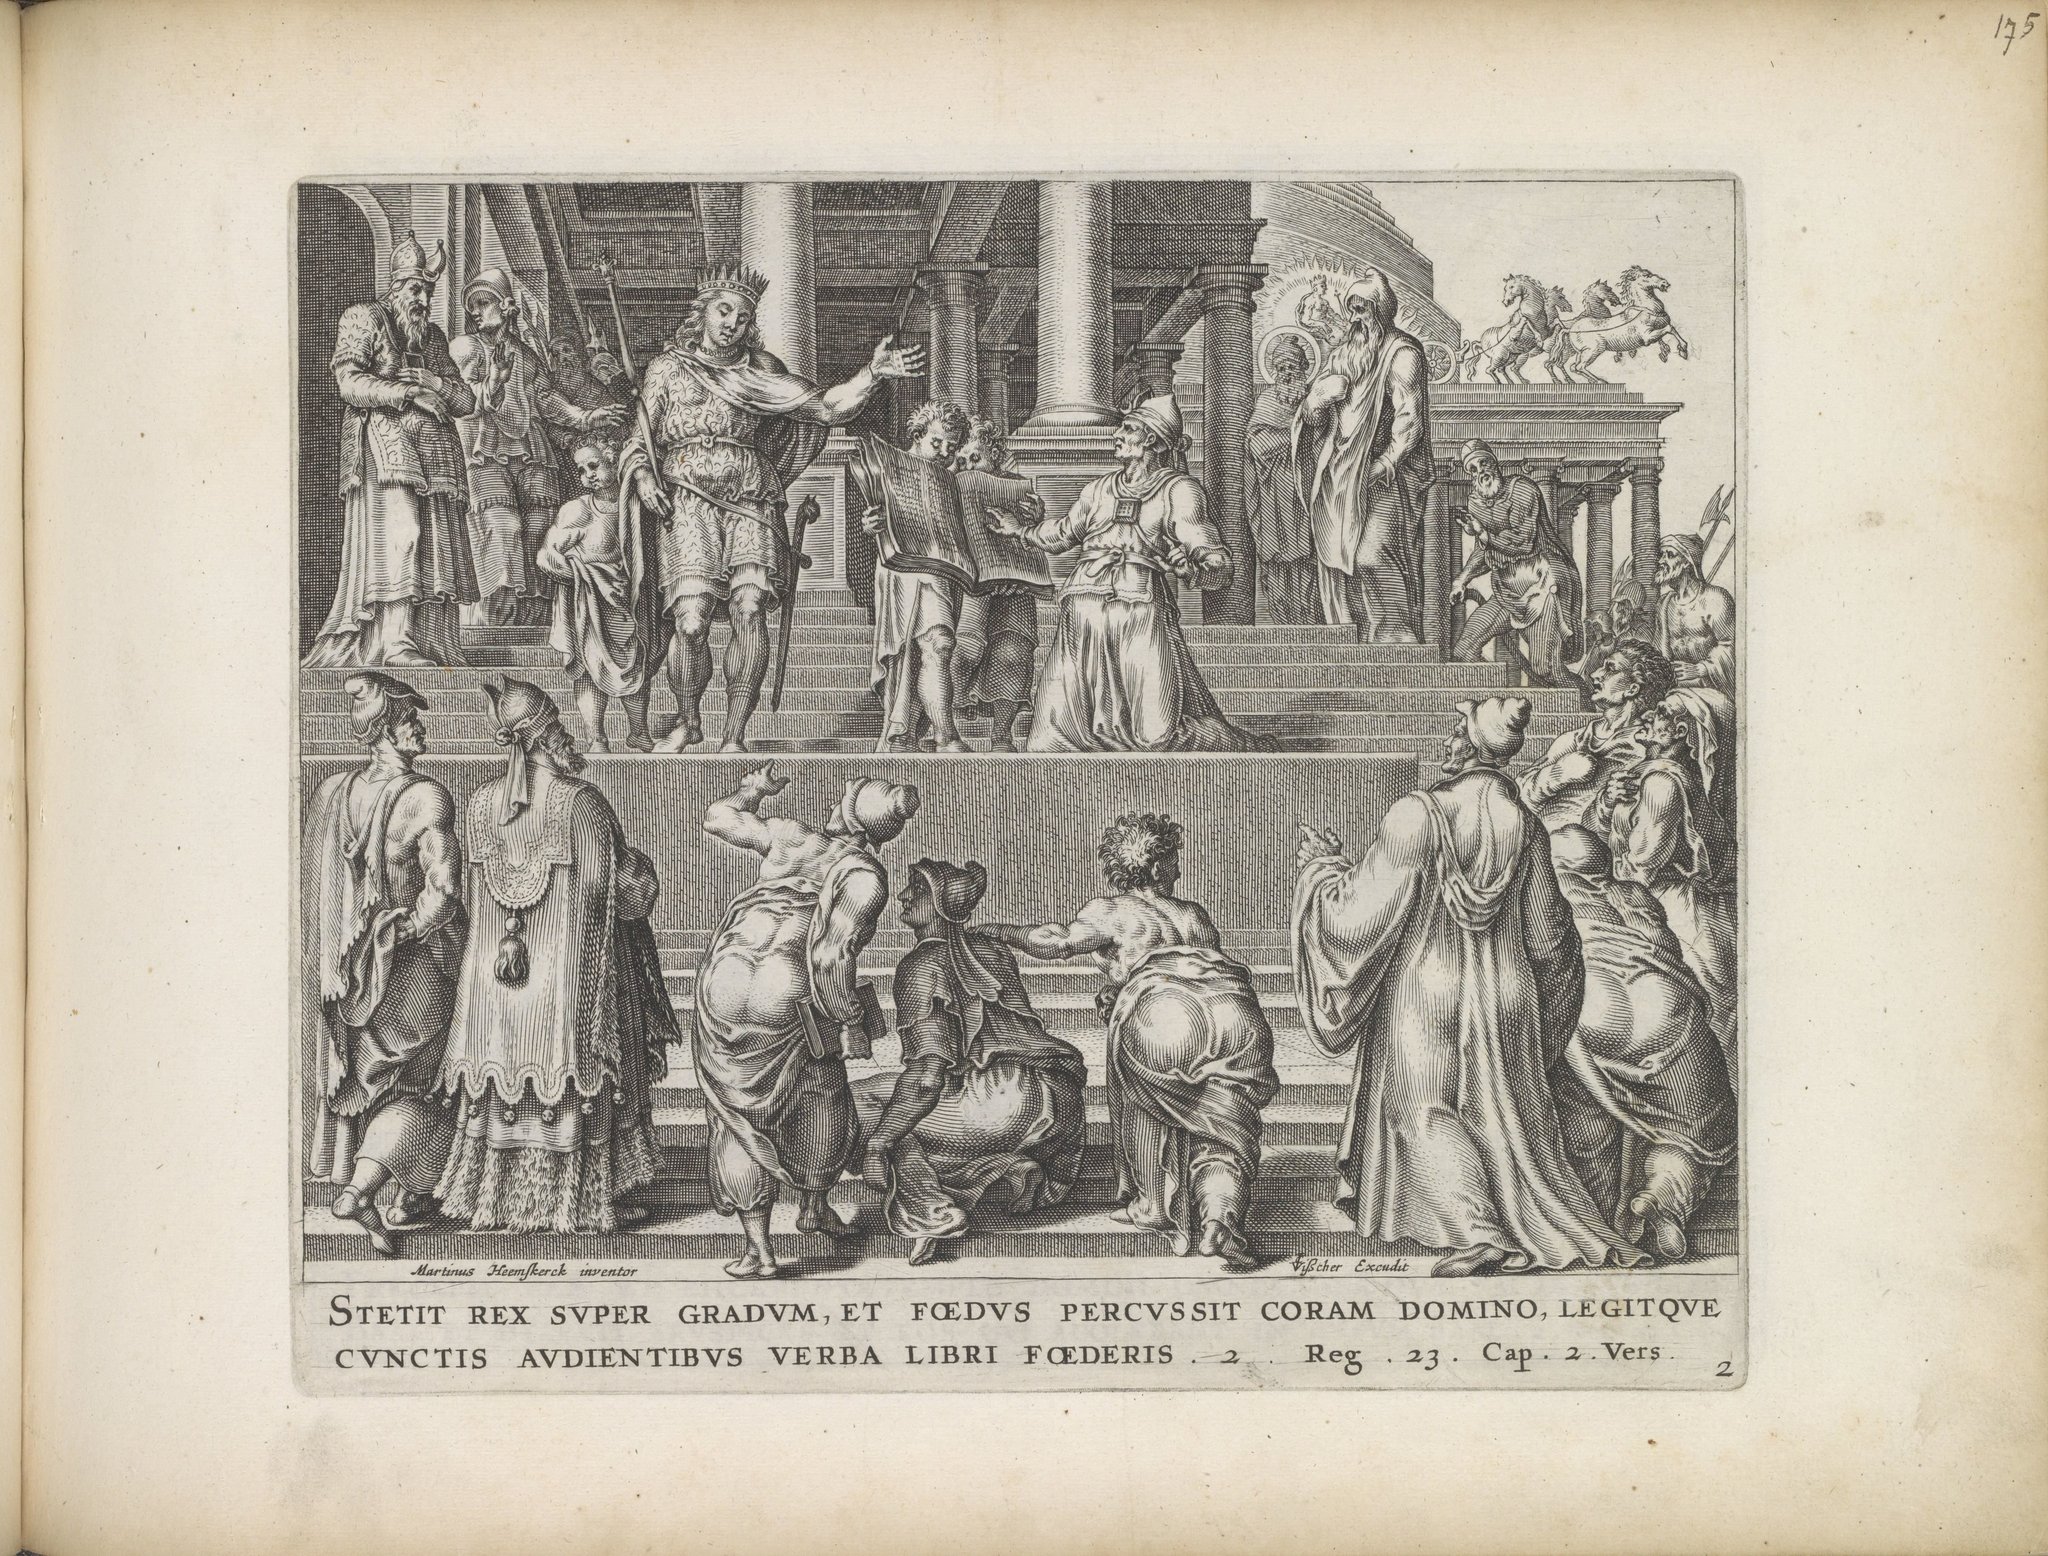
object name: print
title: Koning Josia laat het wetboek aan het volk voorlezen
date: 1643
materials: paper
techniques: engraving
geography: amsterdam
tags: the book of law is discovered ~ story of josiah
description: Koning Josia staat op de trappen van de tempel en laat het teruggevonden wetboek van God voorlezen aan het volk van Israël. Josia heft zijn hand en zweert dat hij God zal volgen en diens wetten zal houden. Onder de voorstelling een verwijzing in het Latijn naar de Bijbeltekst in 2 Kon. 23:2. Deze prent maakt deel uit van een album.